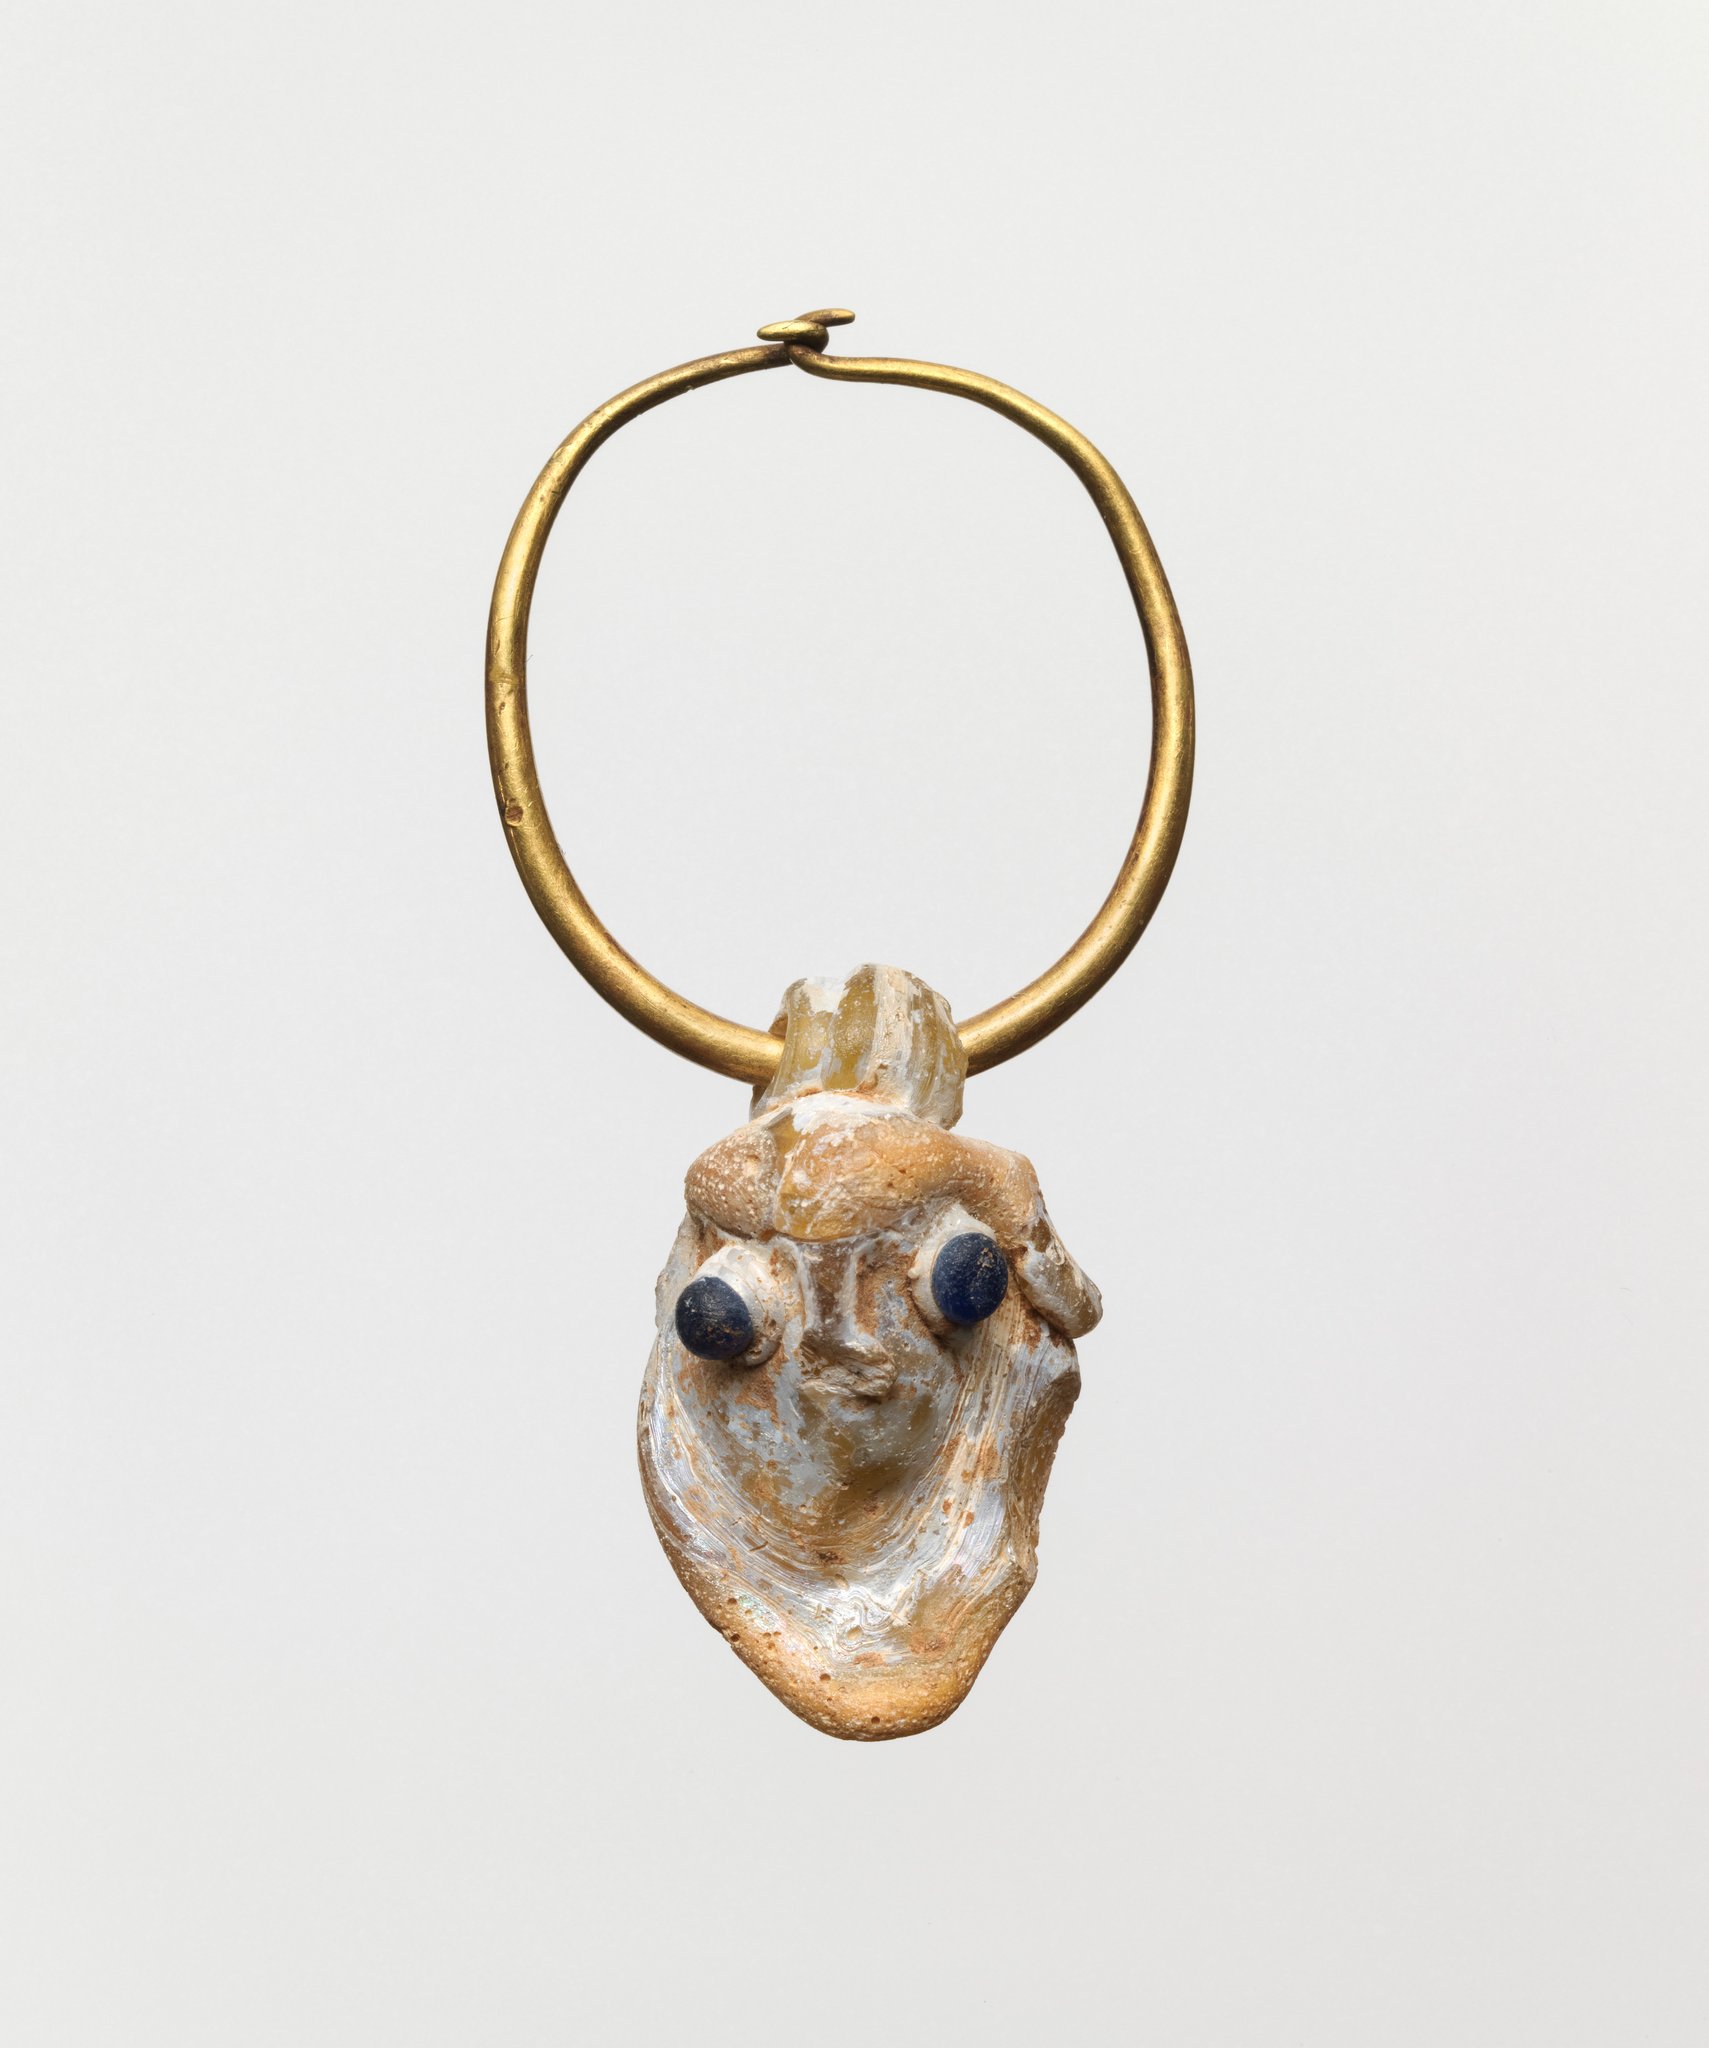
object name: earring with nail head pendant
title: Gold earring with a glass pendant in the form of a demonic mask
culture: carthaginian or phoenician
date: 500-451 BCE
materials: glass, gold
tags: masks